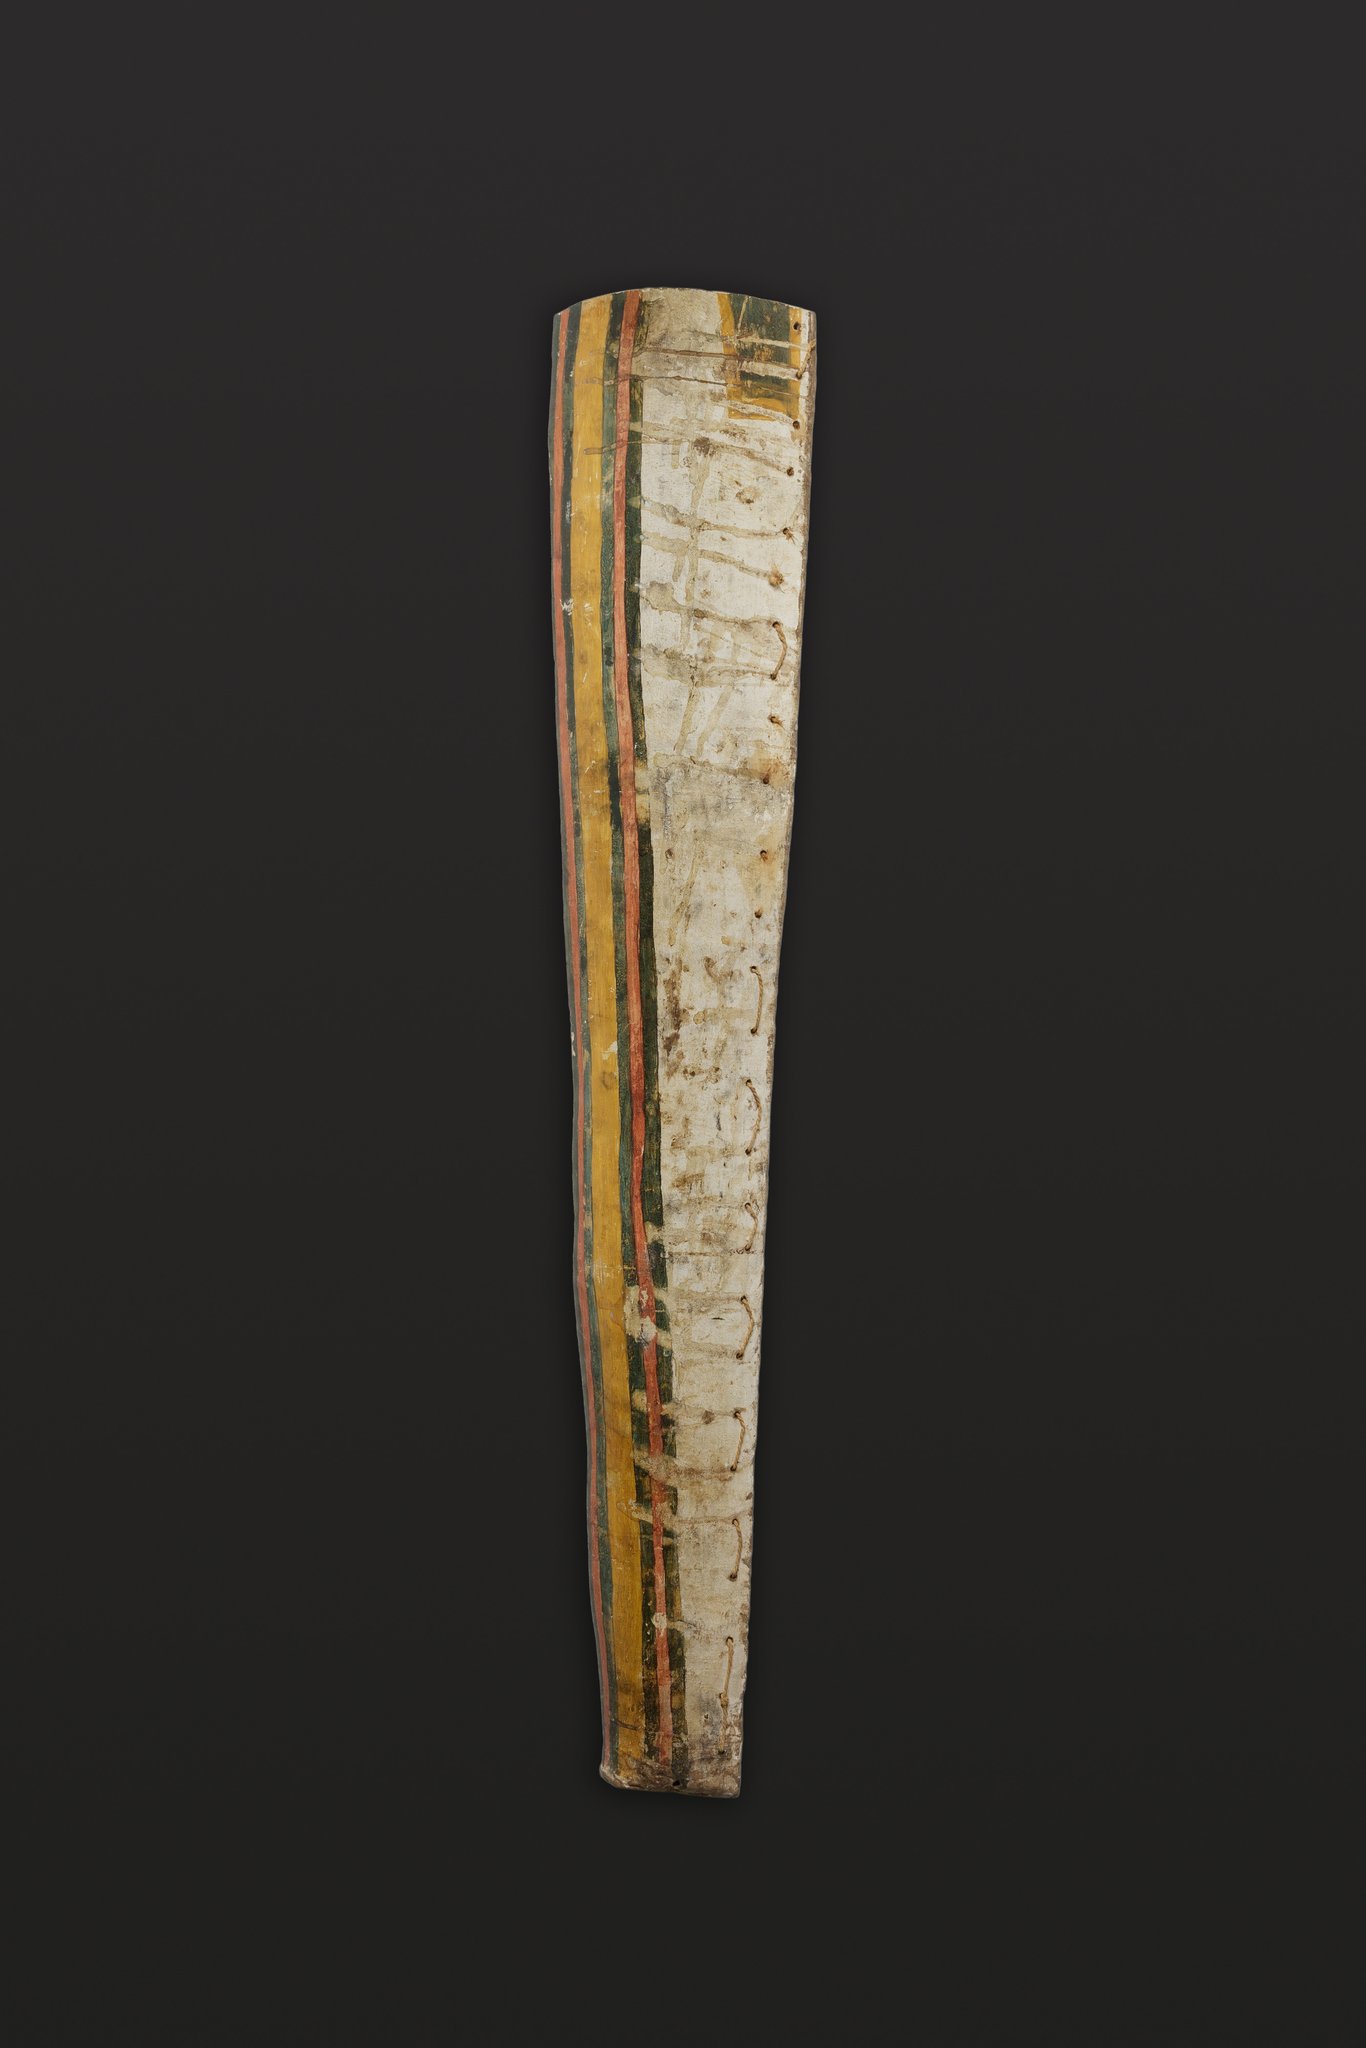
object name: cartonnage, tjaisetemneny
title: Section cut from back of cartonnage of Tjaisetemneny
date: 1070-945 BCE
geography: egypt